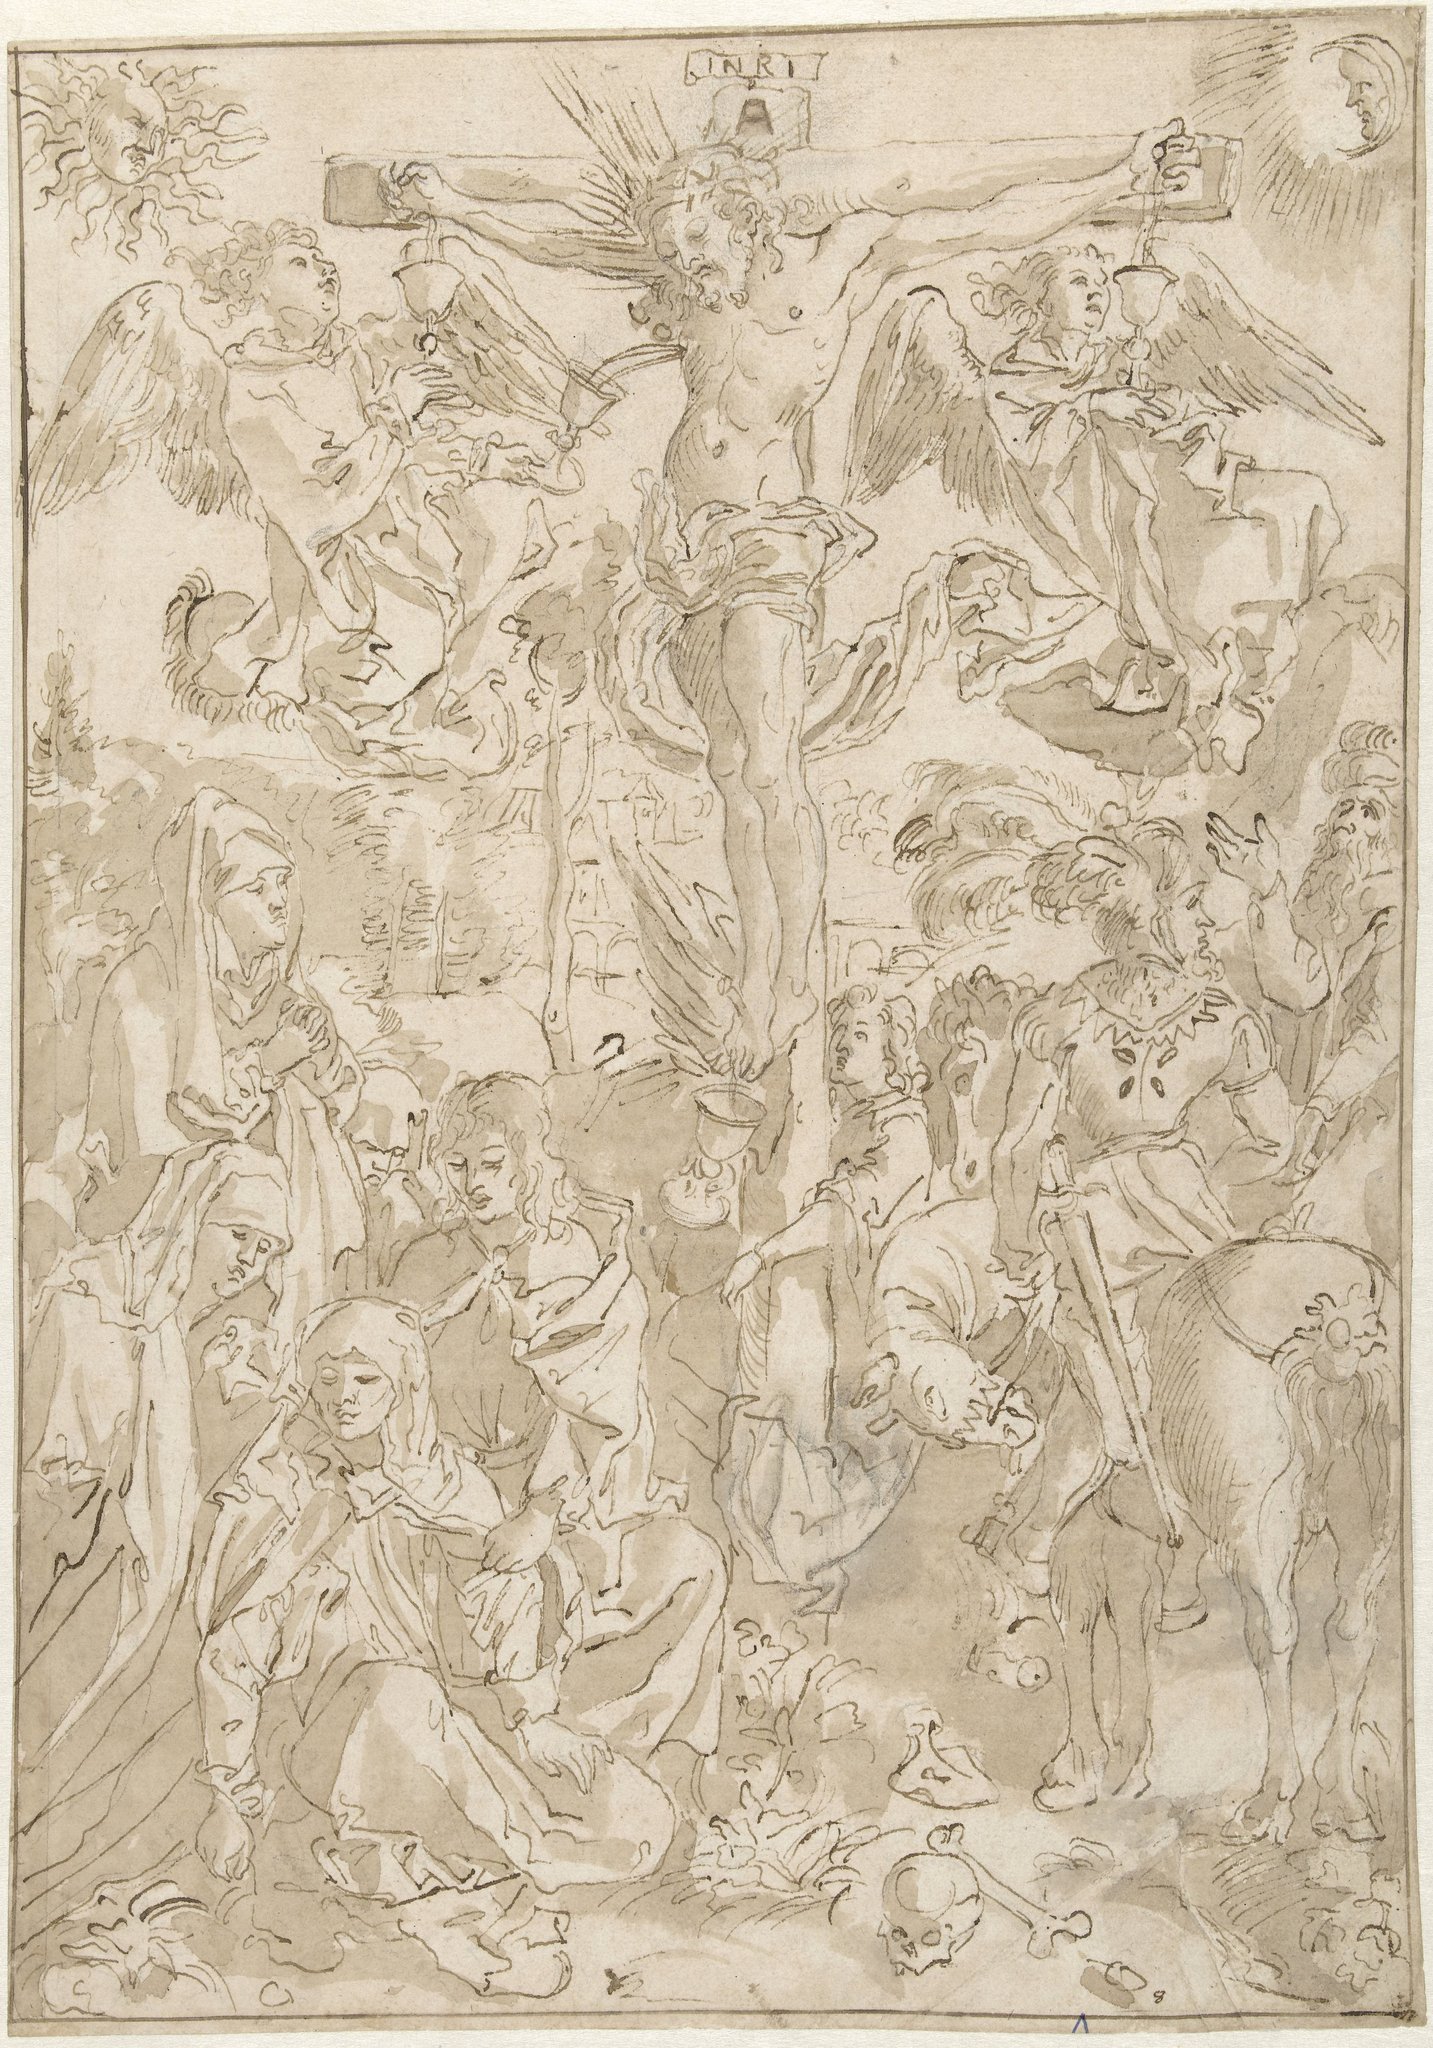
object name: drawing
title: Christus aan het kruis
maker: Anonymous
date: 1500-1600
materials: chalk, ink, paper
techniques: brush, pen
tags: angel(s) catching christ's blood in cup(s)